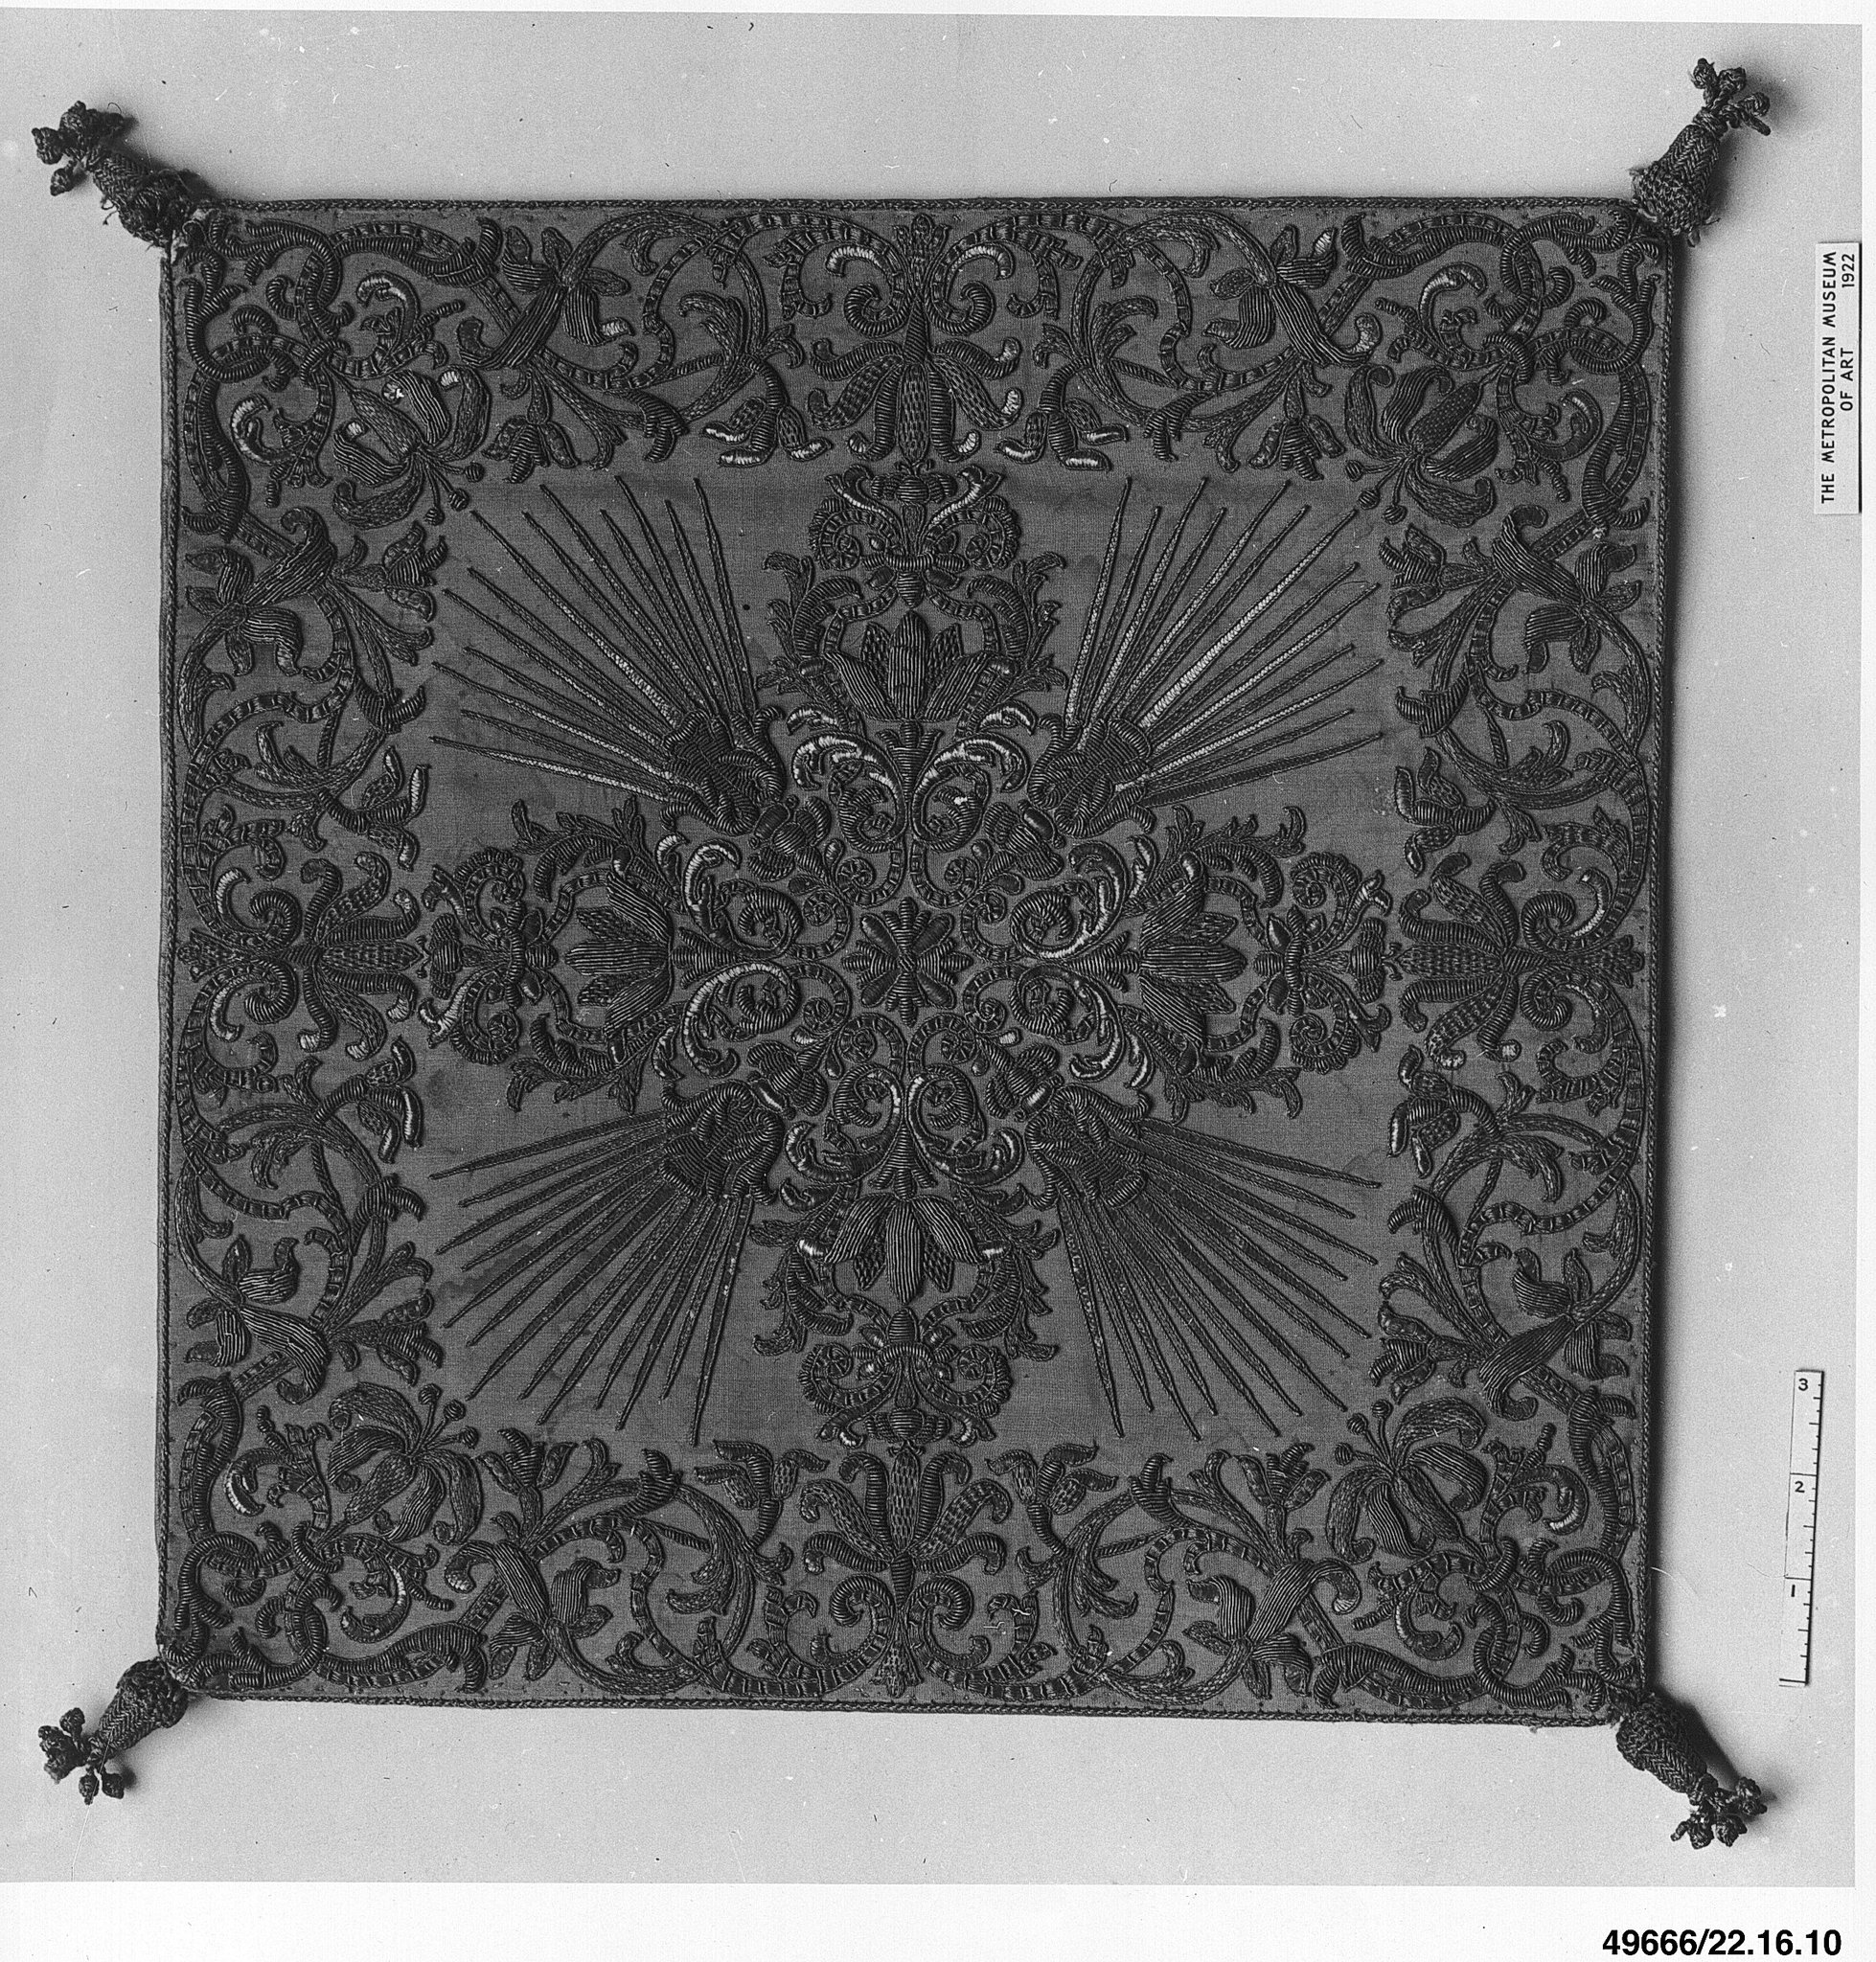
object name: burse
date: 1589-1590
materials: metal thread, silk